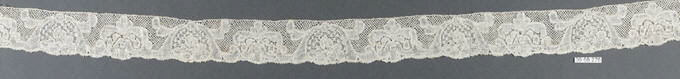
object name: border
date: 1701-1733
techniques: lace